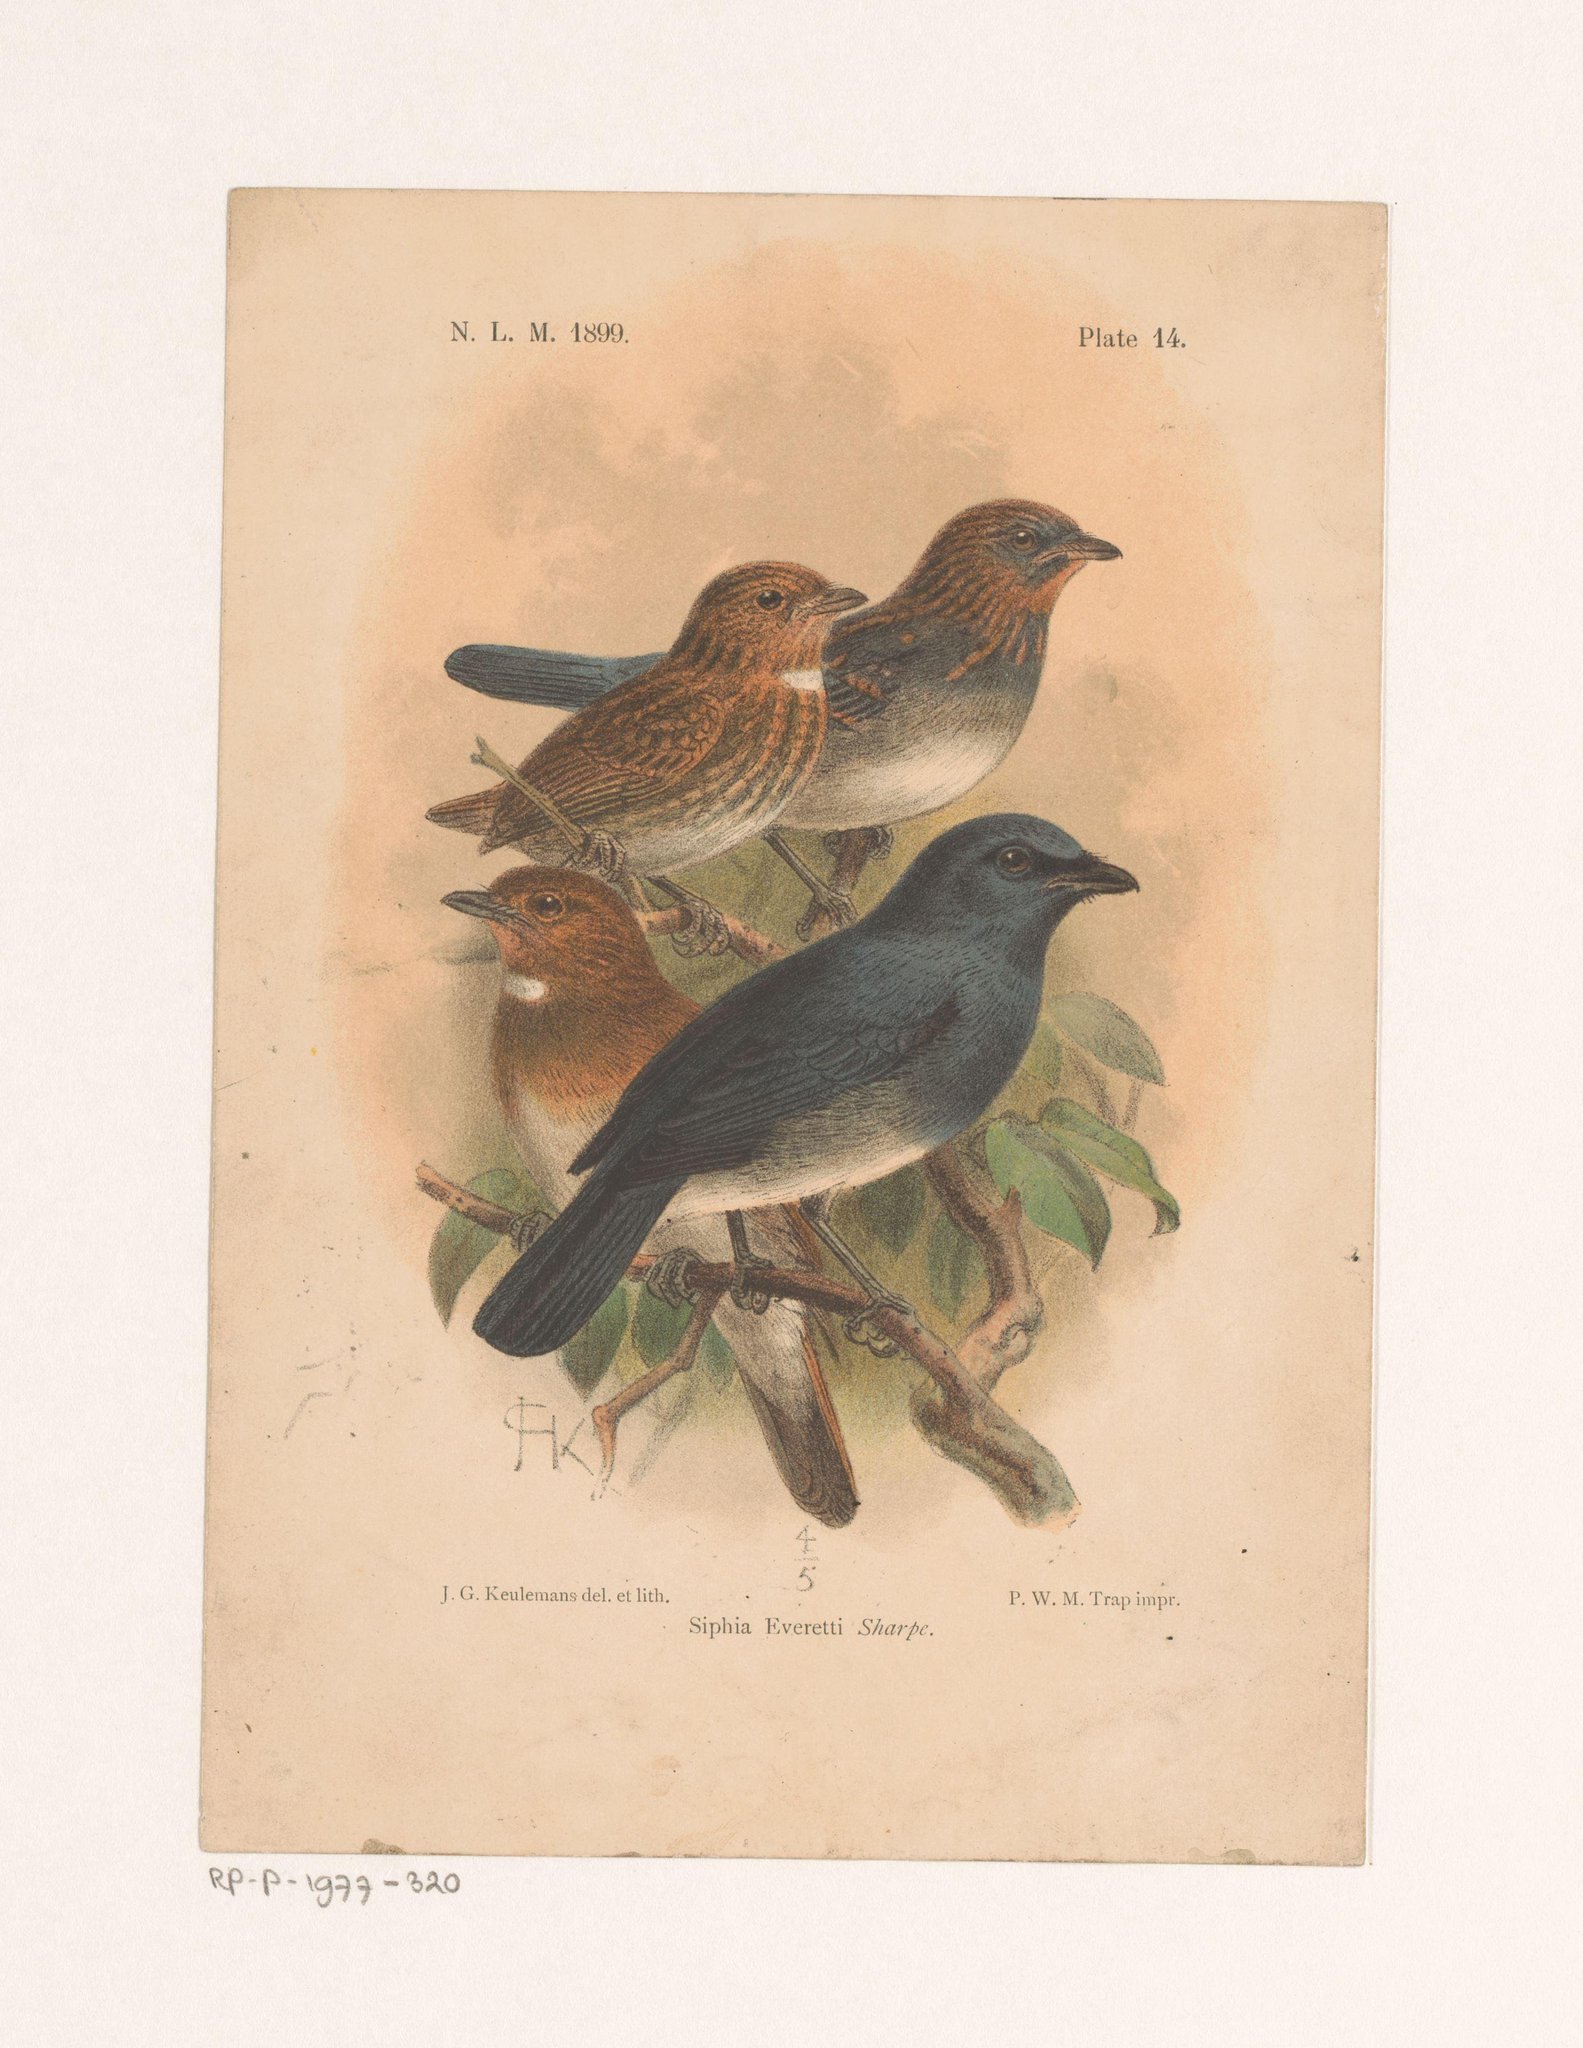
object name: print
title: Siphia Everetti Sharpe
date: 1899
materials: paper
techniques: lithograph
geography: leiden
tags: trees (+ branch, stick), birds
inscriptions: collector's mark: Lugt 2228